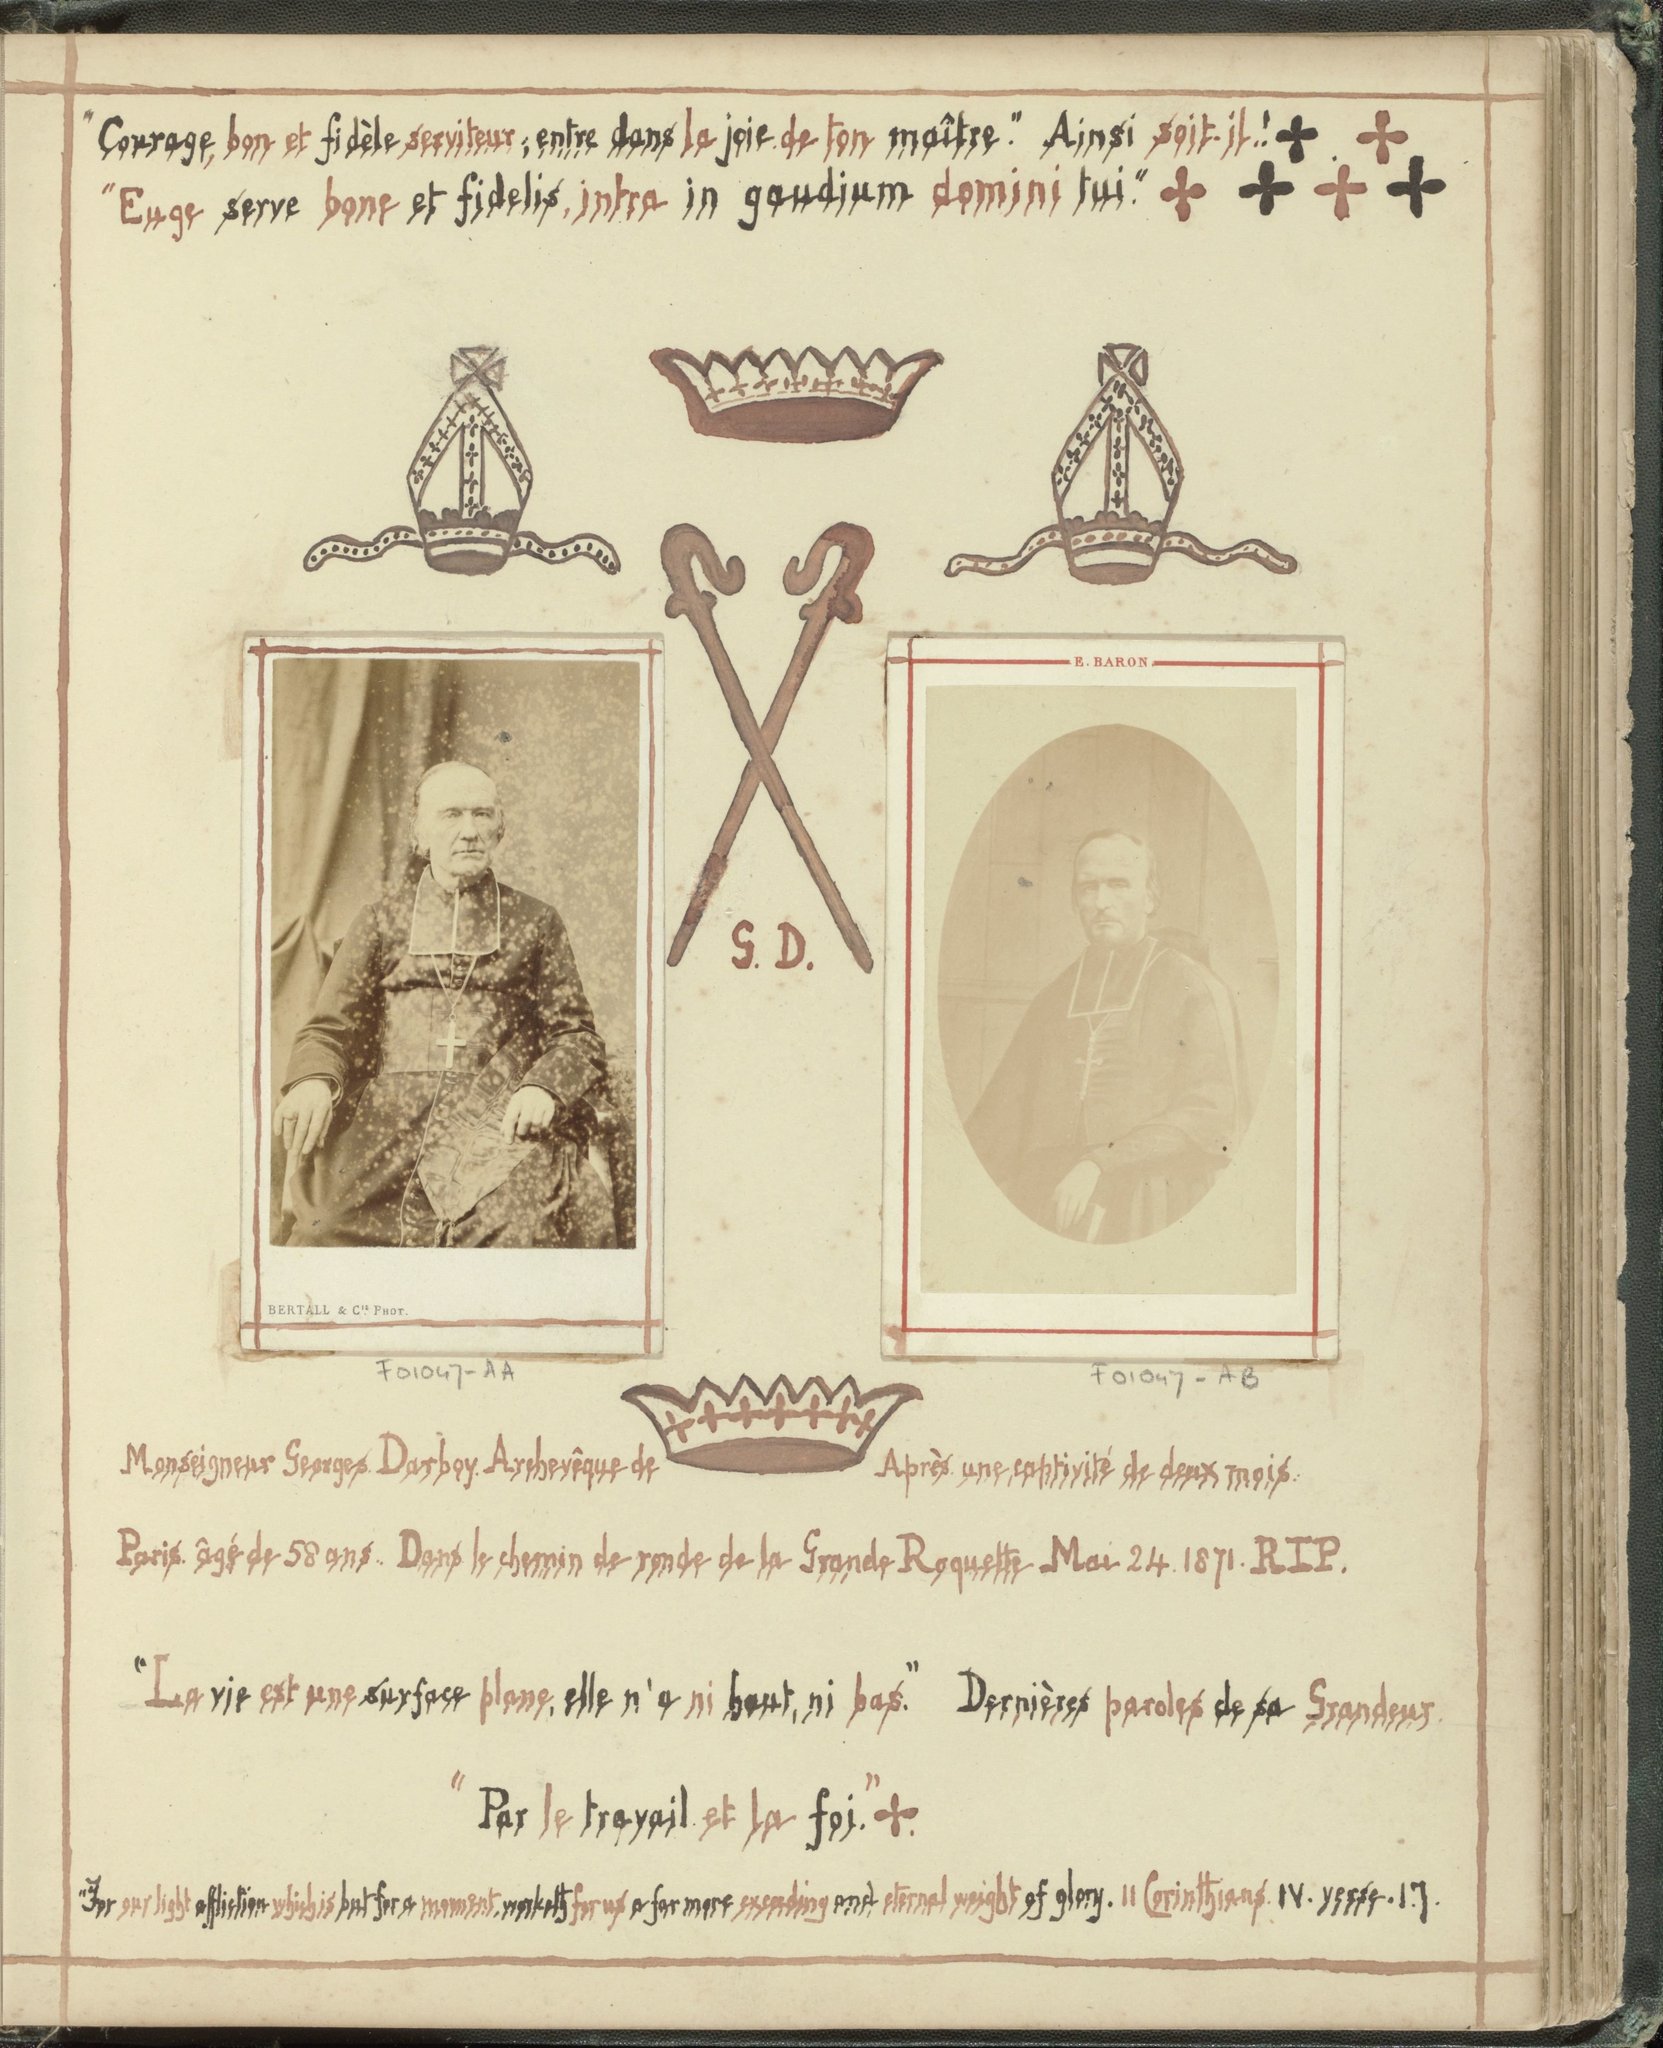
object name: carte de visite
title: Portret van monseigneur Georges Darboy, aartsbisschop van Parijs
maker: eugène baron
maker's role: fotograaf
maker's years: 1843-1865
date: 1871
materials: cardboard, paper, photographic support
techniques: albumen print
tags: archbishop, bishop, etc. (roman catholic), priest (roman catholic)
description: Onderdeel van Herdenkingsalbum van rooms-katholieke geestelijken gevallen tijdens de Commune van Parijs.